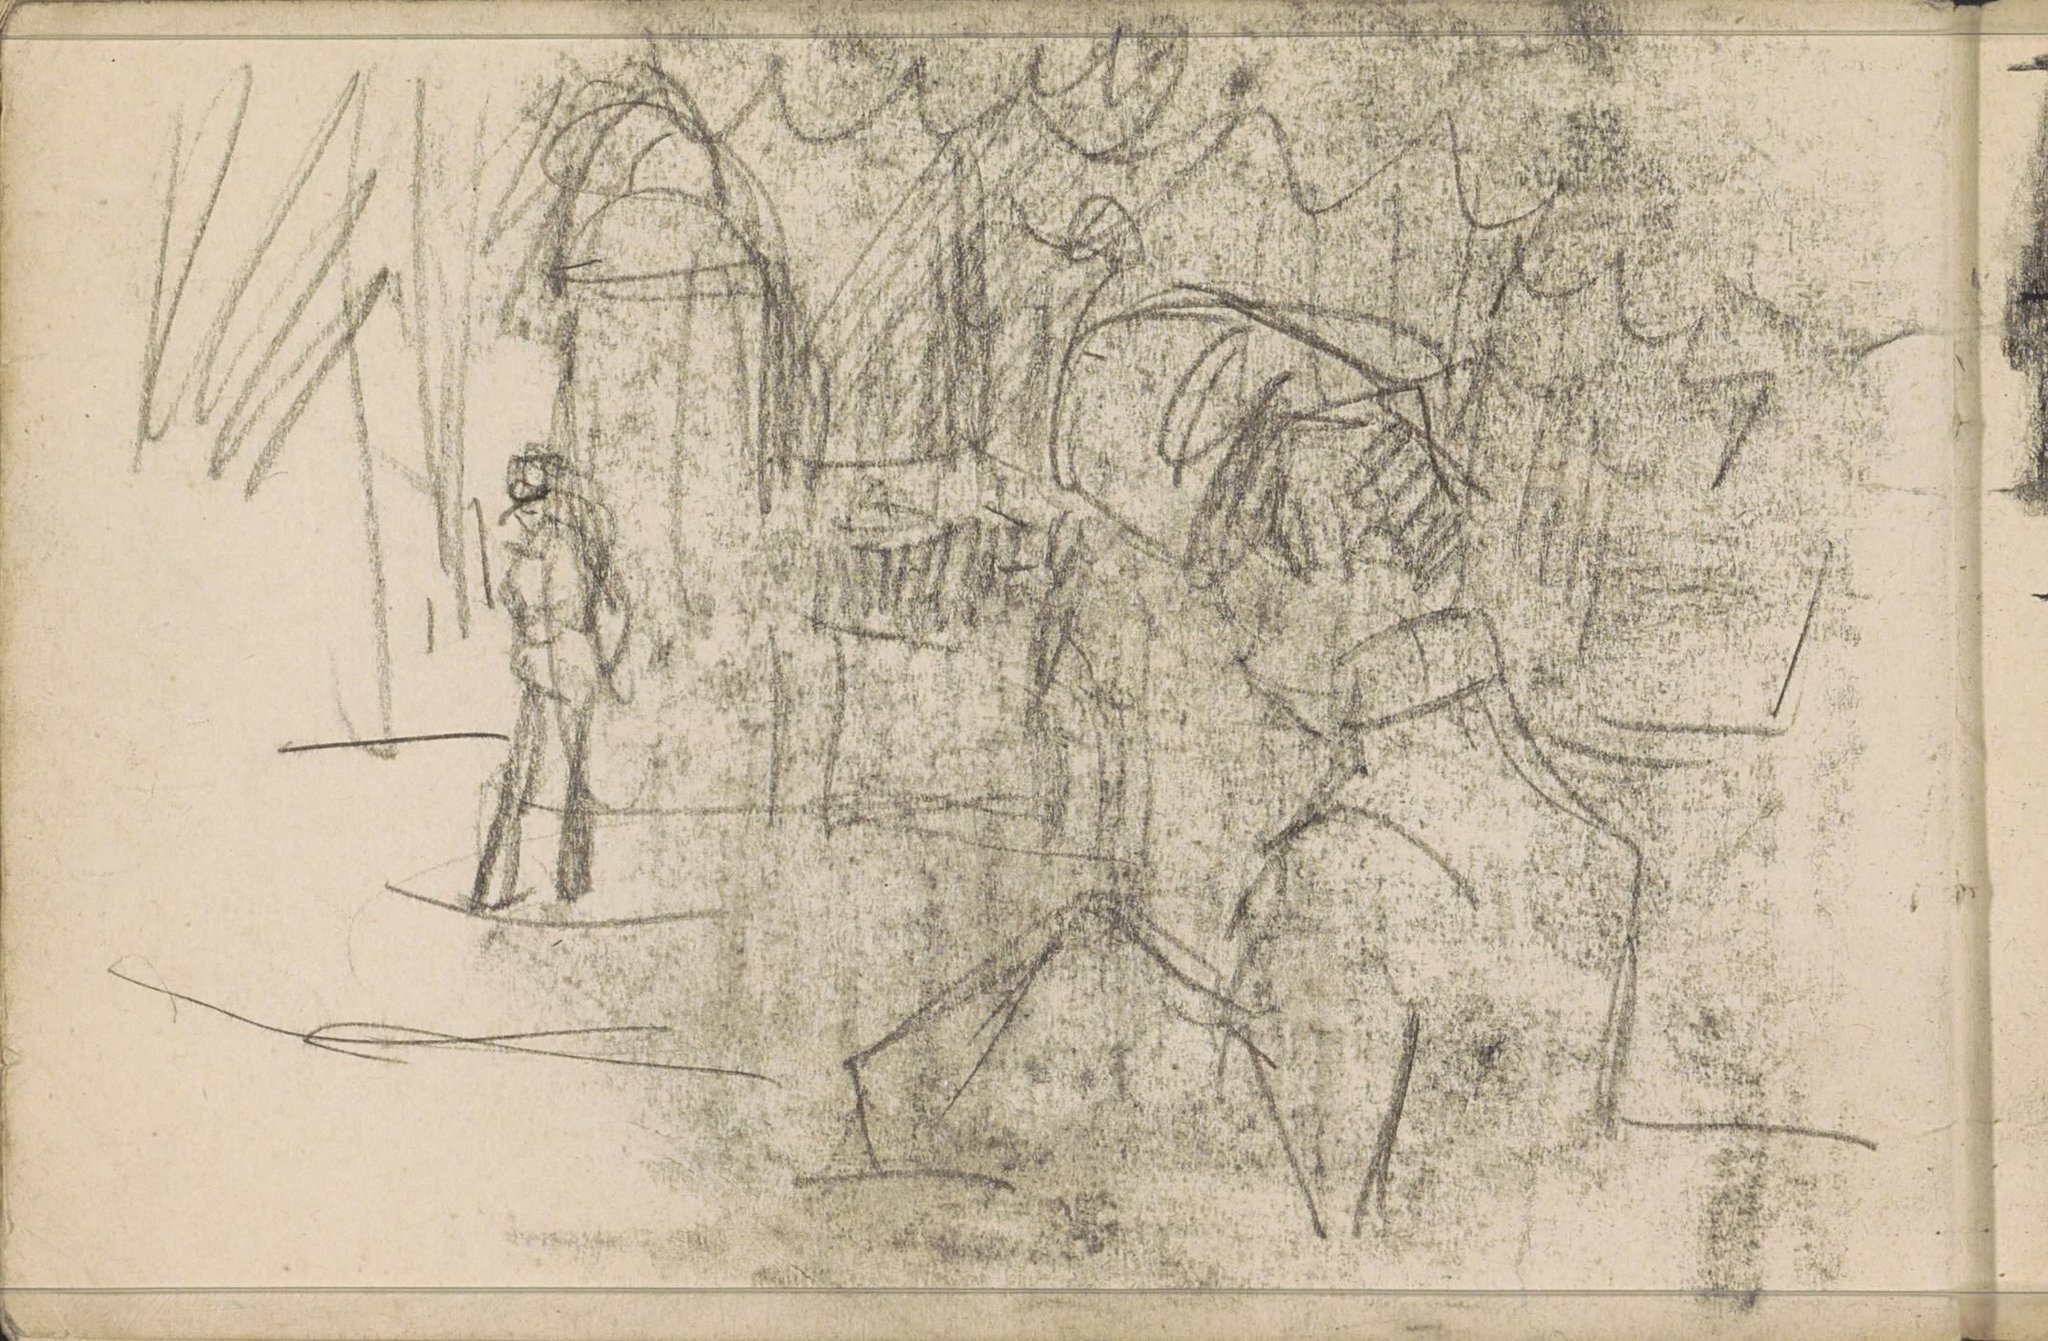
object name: sketchbook leaf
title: Figuren op straat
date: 1875-1934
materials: chalk, paper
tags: street (+ city(-scape) with figures, staffage)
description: Pagina 30 uit schetsboek XLVI met 32 pagina's.